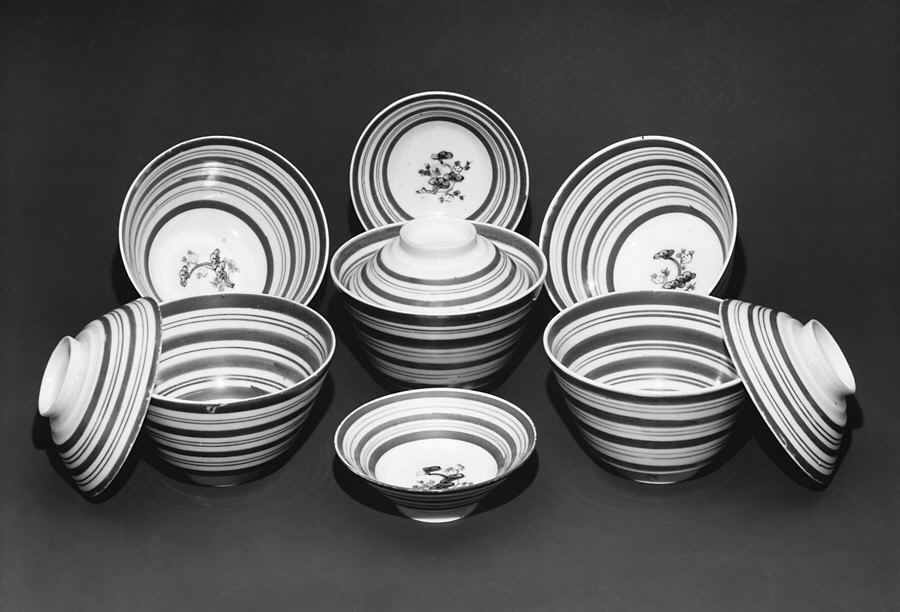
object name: covered bowl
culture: japanese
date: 1701-1800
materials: porcelain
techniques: underglaze